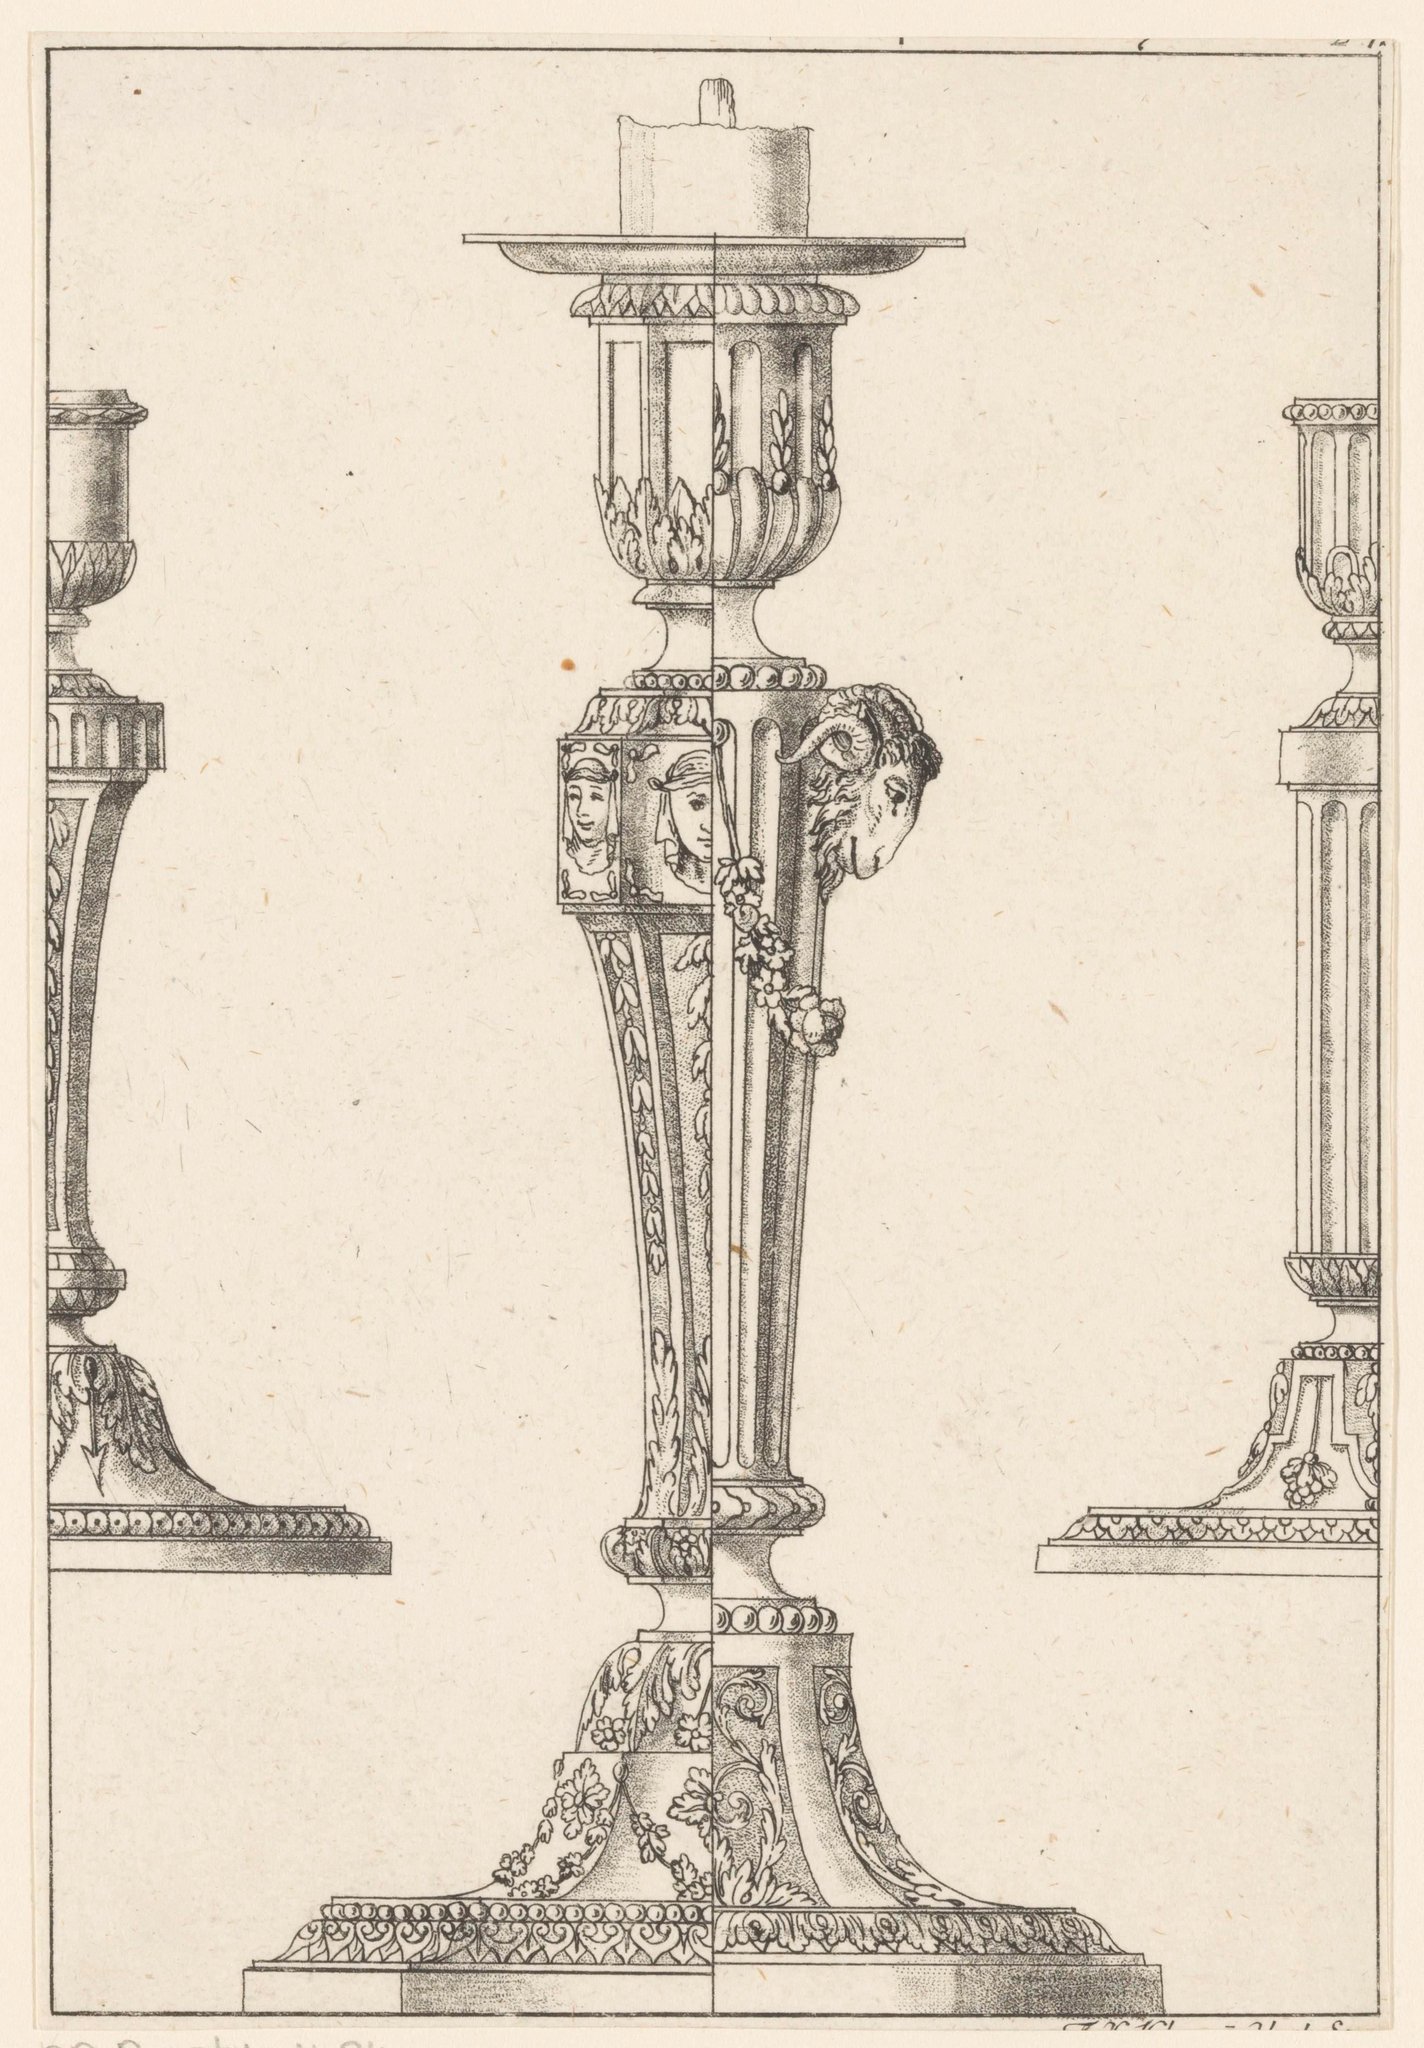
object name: ornament print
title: Ontwerpen van zilverwerk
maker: franz xaver habermann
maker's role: draughtsman, print maker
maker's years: 1721-1796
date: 1731-1796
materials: paper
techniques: etching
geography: germany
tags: chandelier, candelabrum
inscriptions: collector's mark: Lugt 2760, collector's mark: Lugt 2228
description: Drie tafelkandelaars met bladmotieven, ornamenten, gezichten en bokkenkop.